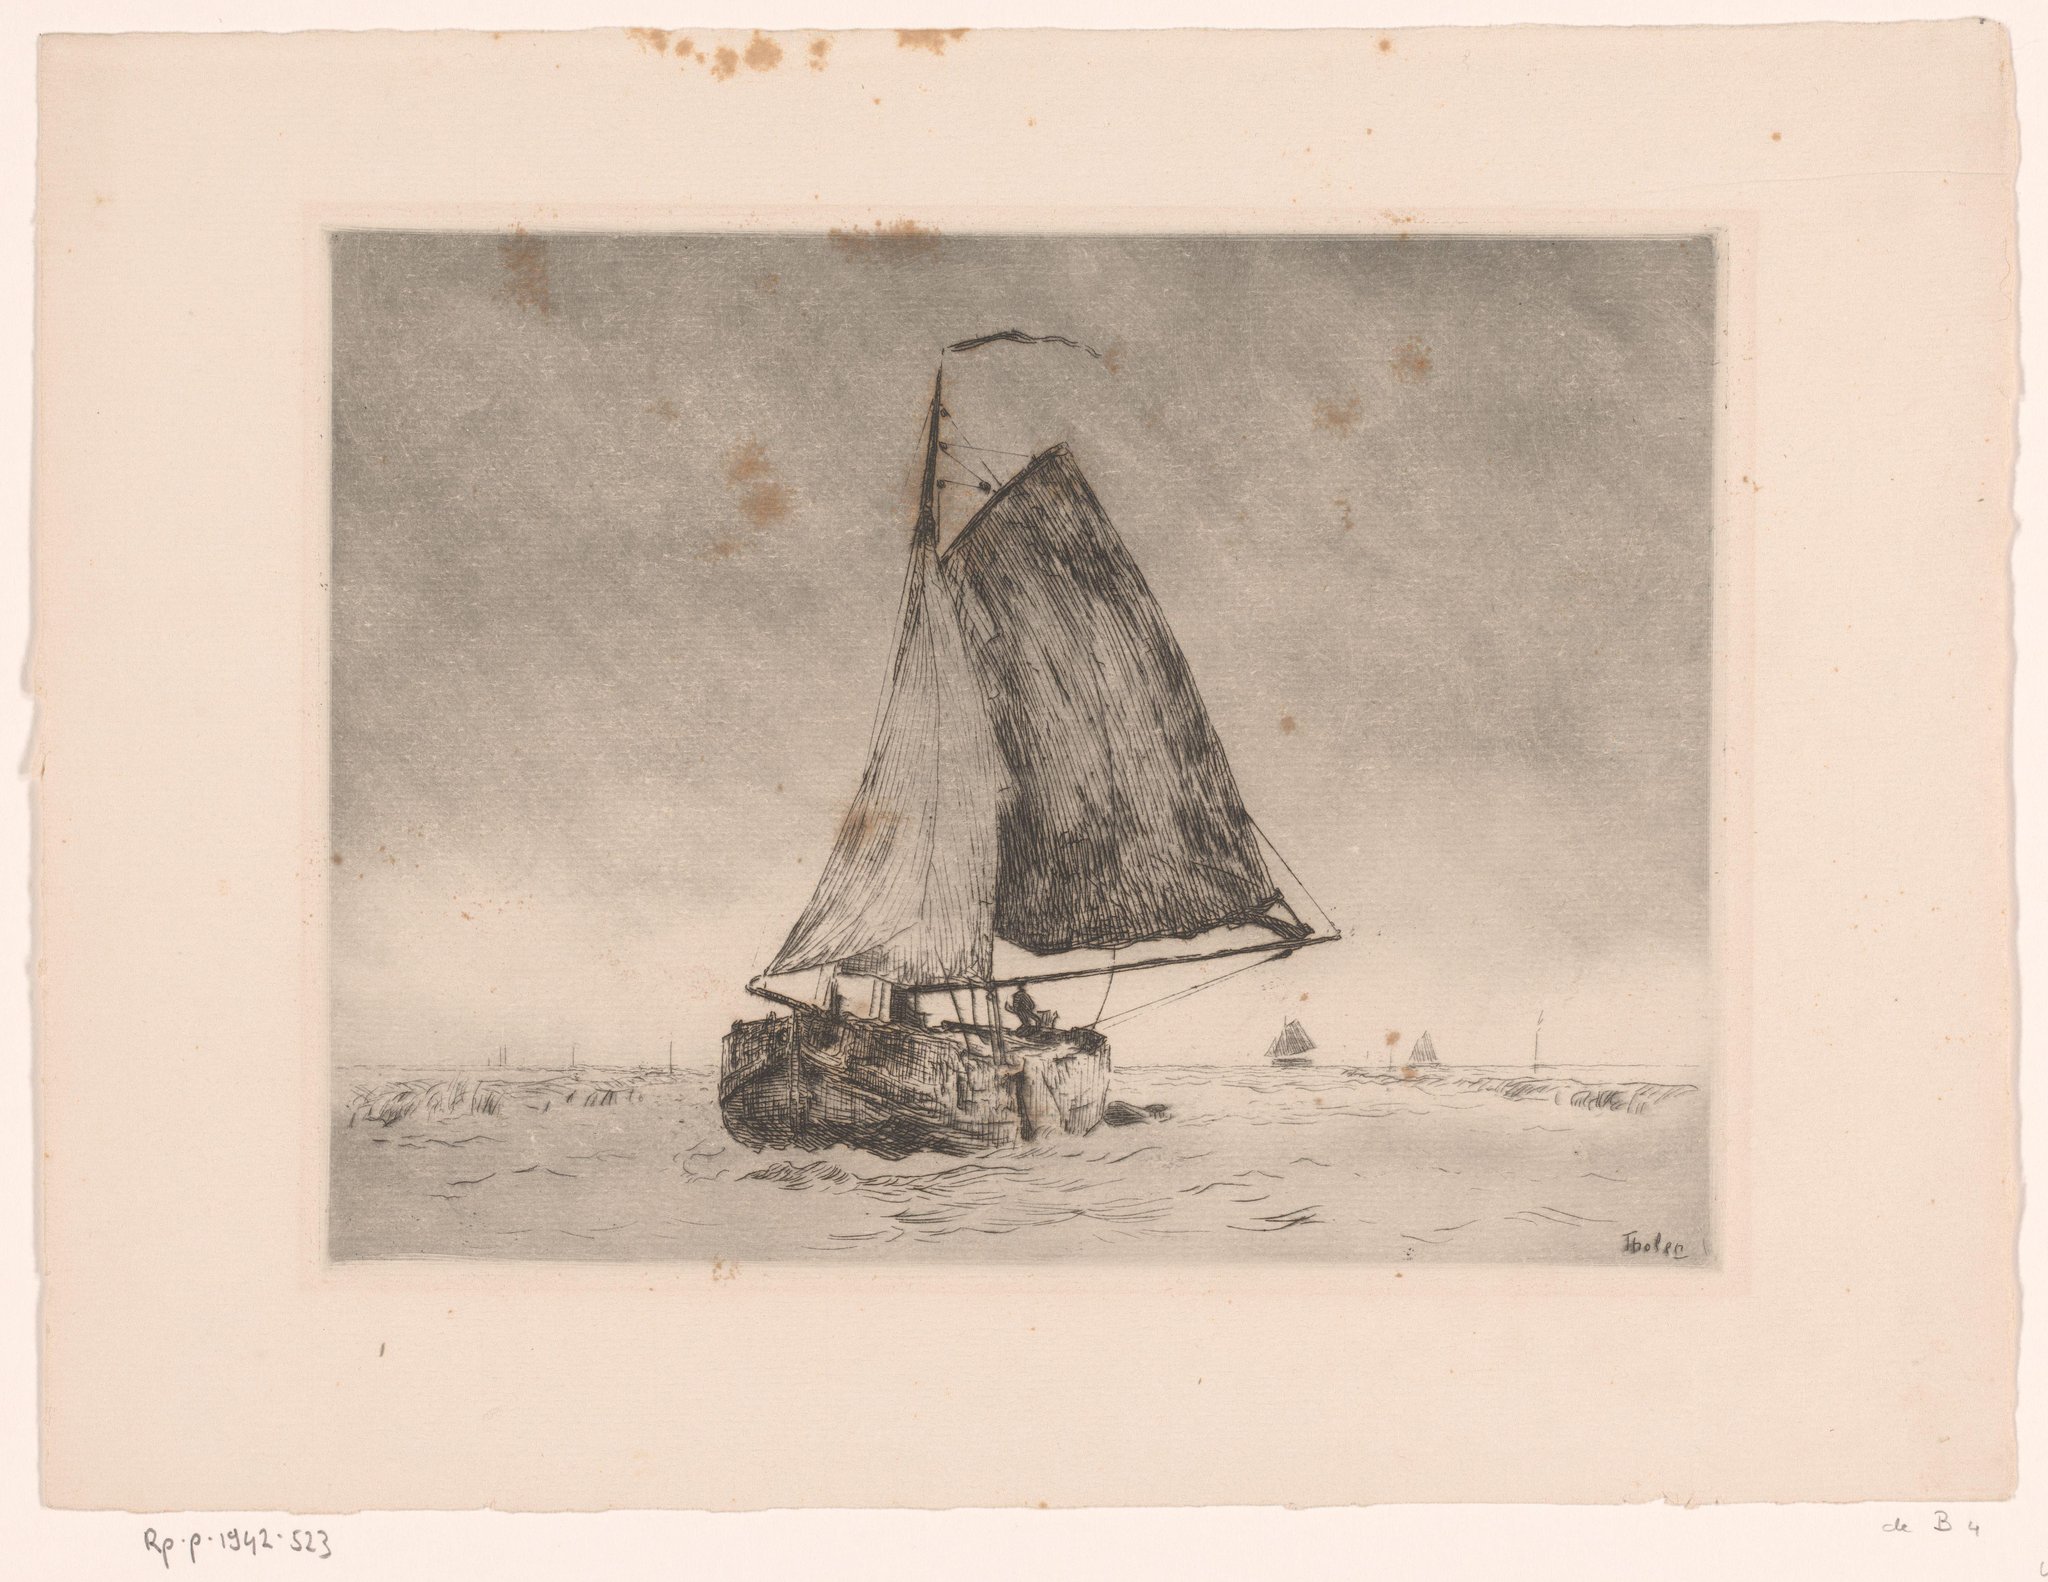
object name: print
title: Zeilende praam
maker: willem bastiaan tholen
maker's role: draughtsman, painter, print maker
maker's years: 1860-1931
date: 1870-1931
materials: paper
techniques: etching, intaglio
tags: sailing-ship, sailing-boat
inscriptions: collector's mark: Lugt 2228